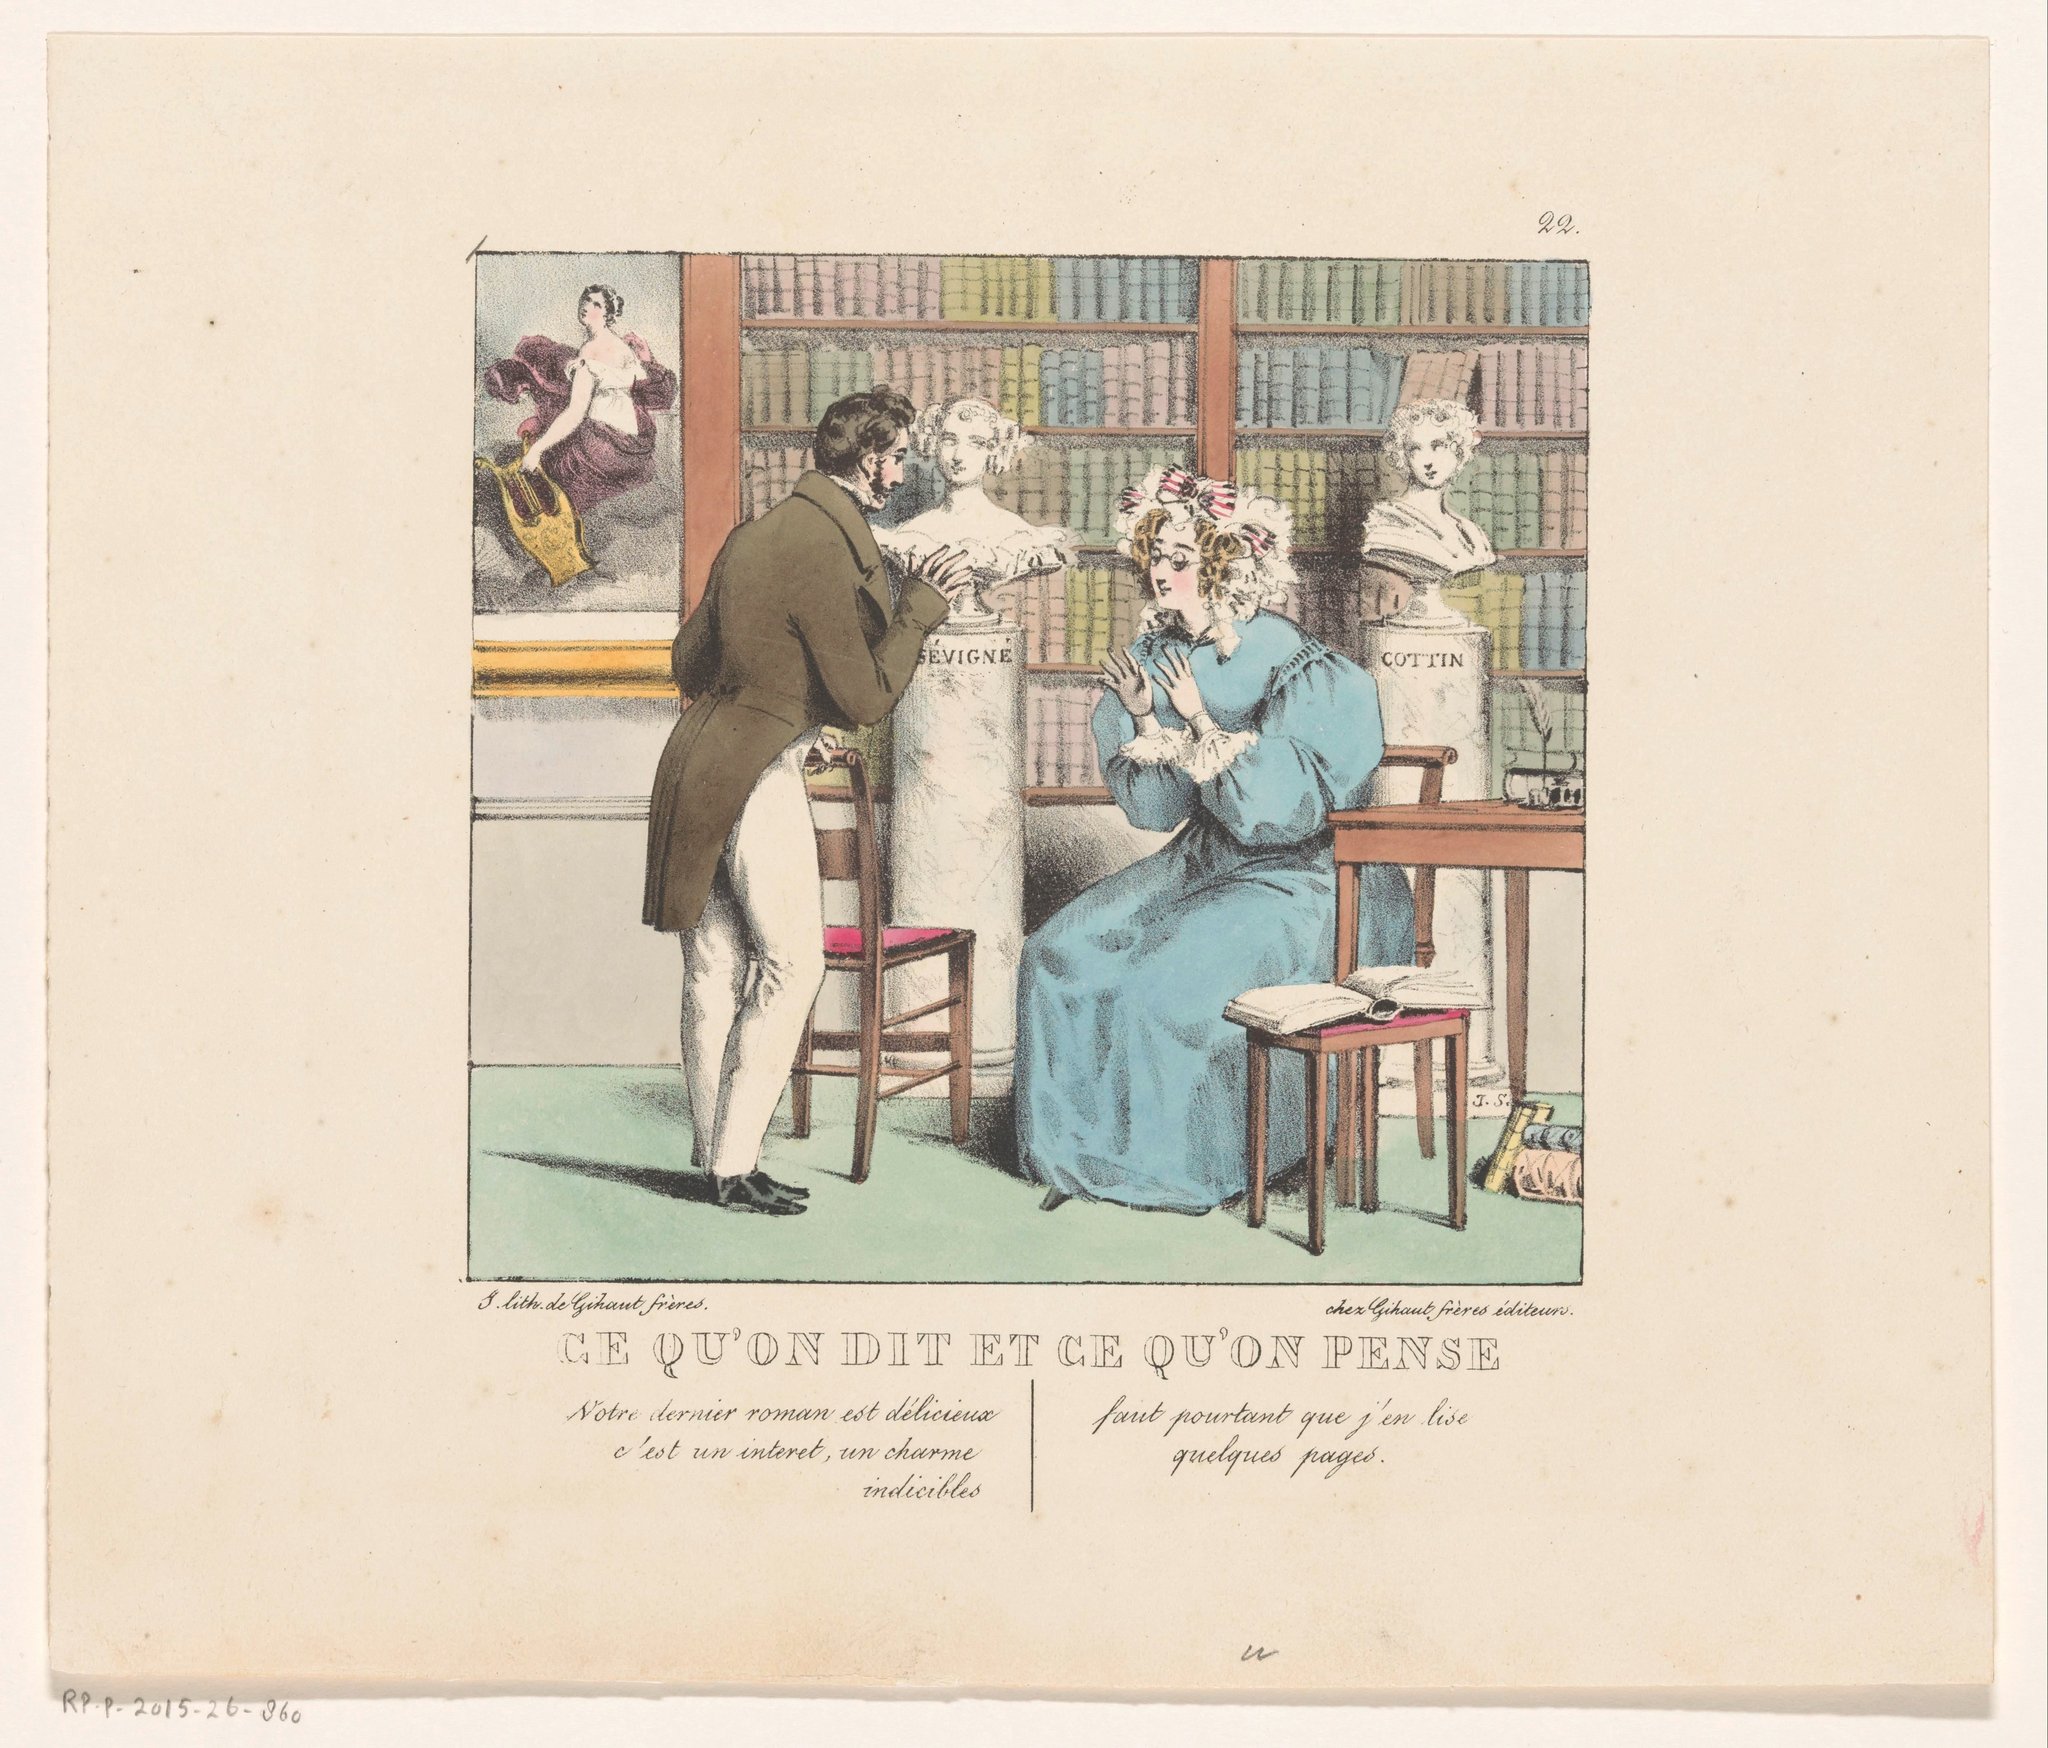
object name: print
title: Wat mensen zeggen en wat ze denken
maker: jean gabriel scheffer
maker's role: painter, print maker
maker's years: 1797-1876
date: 1829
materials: paper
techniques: hand coloring, lithograph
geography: paris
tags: bookshelves, writer, poet, author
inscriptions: collector's mark: Lugt 4779, collector's mark: Lugt 2228, collector's mark: Lugt 4780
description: Afkomstig uit de serie 'Ce qu'on dit et ce qu'on pense', bestaande uit een titelprent en 60 prenten.